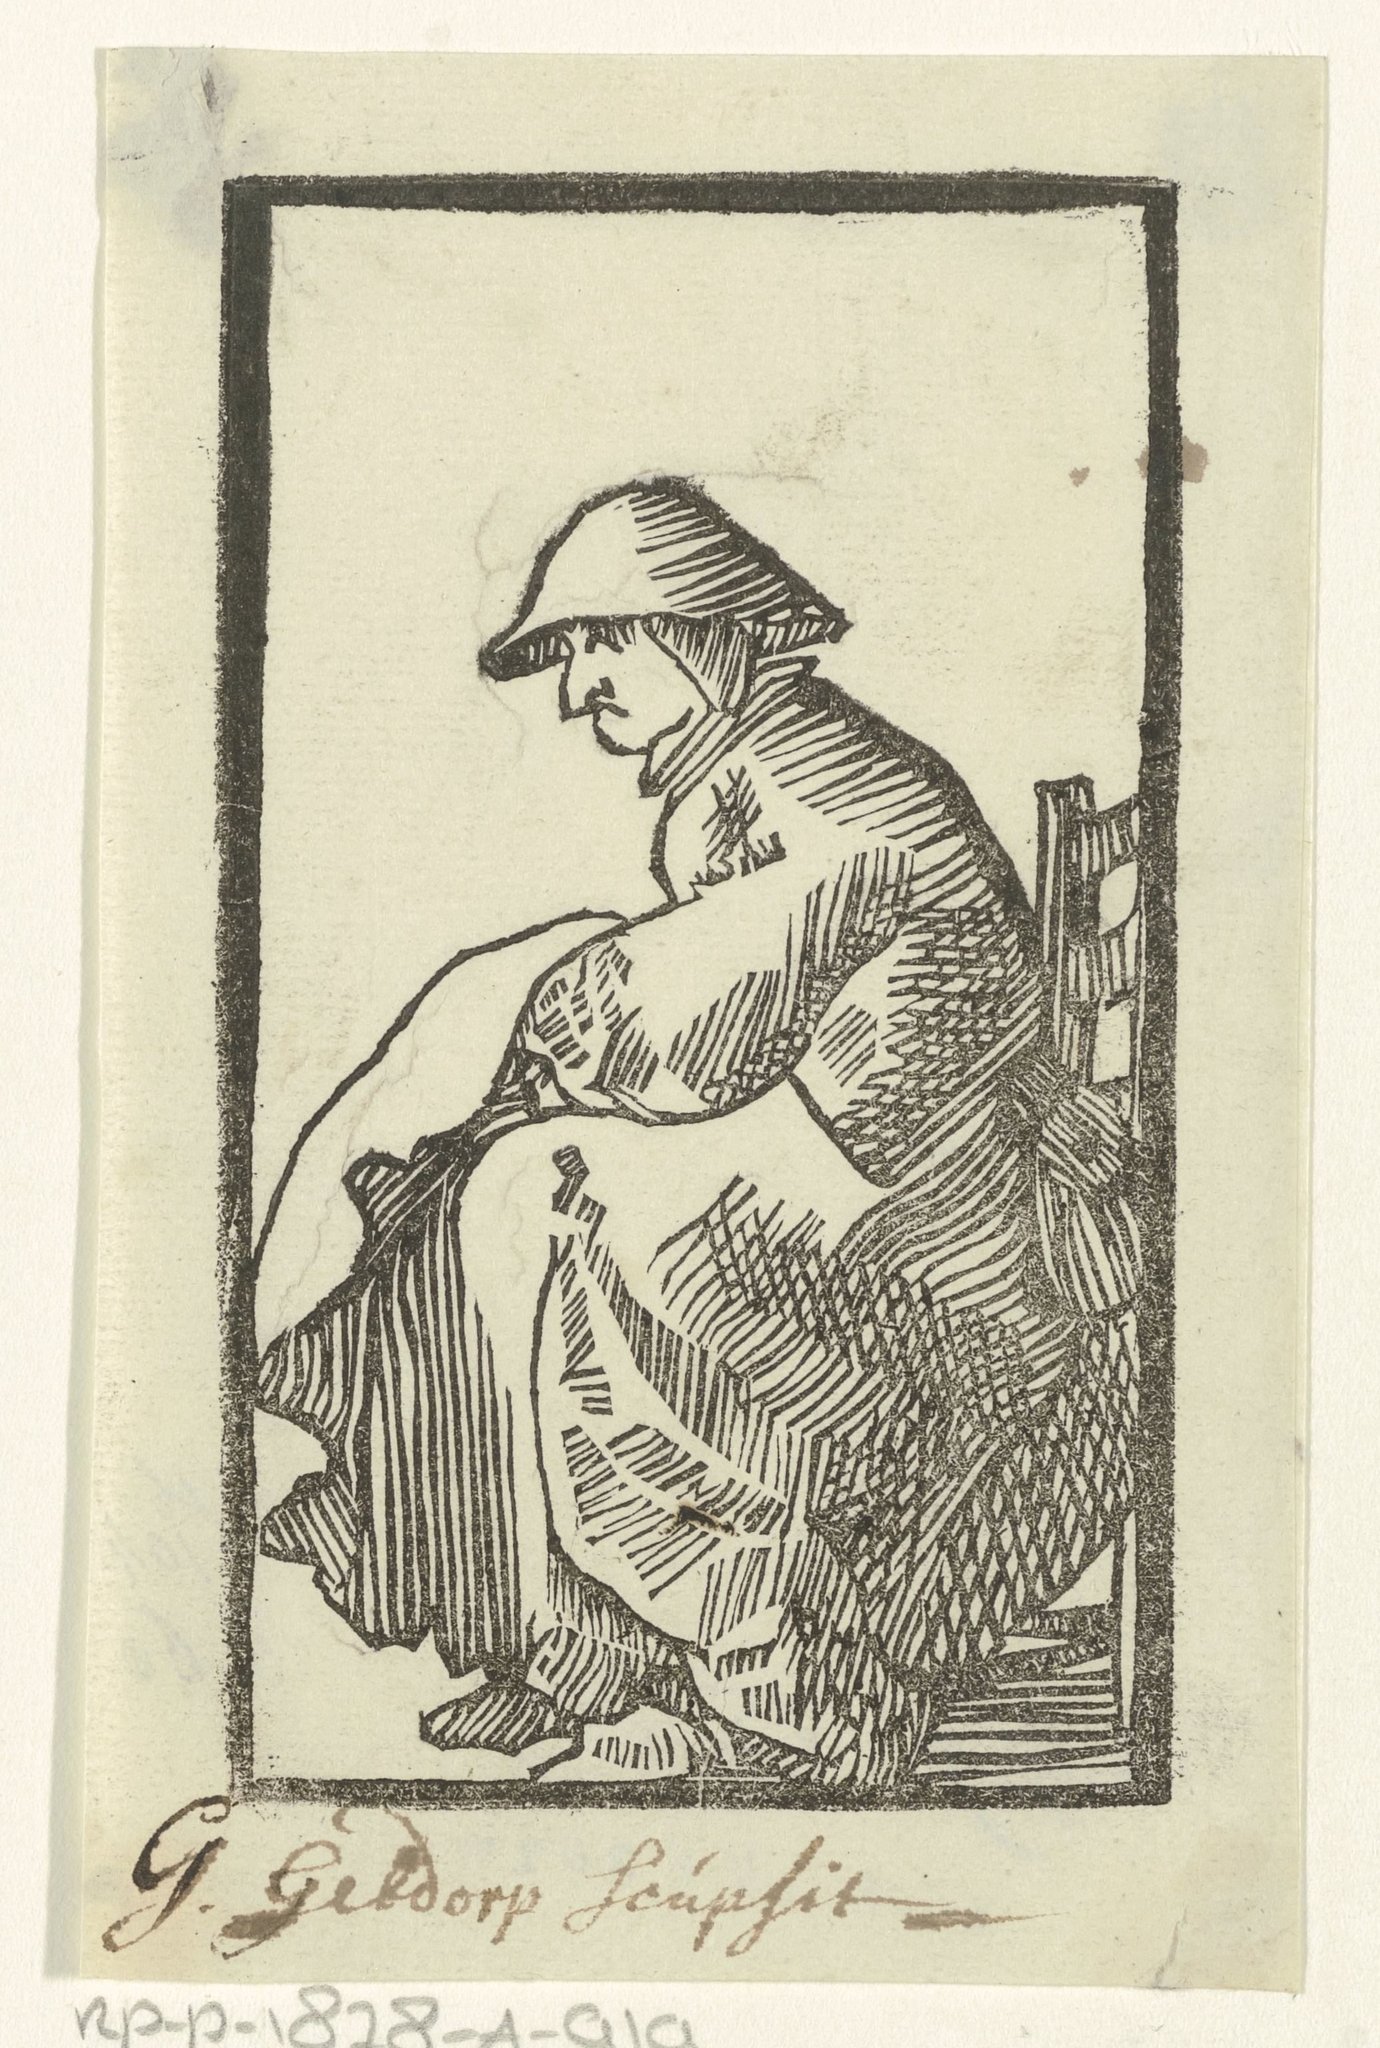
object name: print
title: Zittende boerenvrouw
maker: simon van de passe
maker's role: print maker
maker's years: 1595-1647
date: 1605-1647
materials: paper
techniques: woodcut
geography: netherlands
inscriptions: inscription: ‘G. Geldorp Scupsit’, collector's mark: Lugt 2228